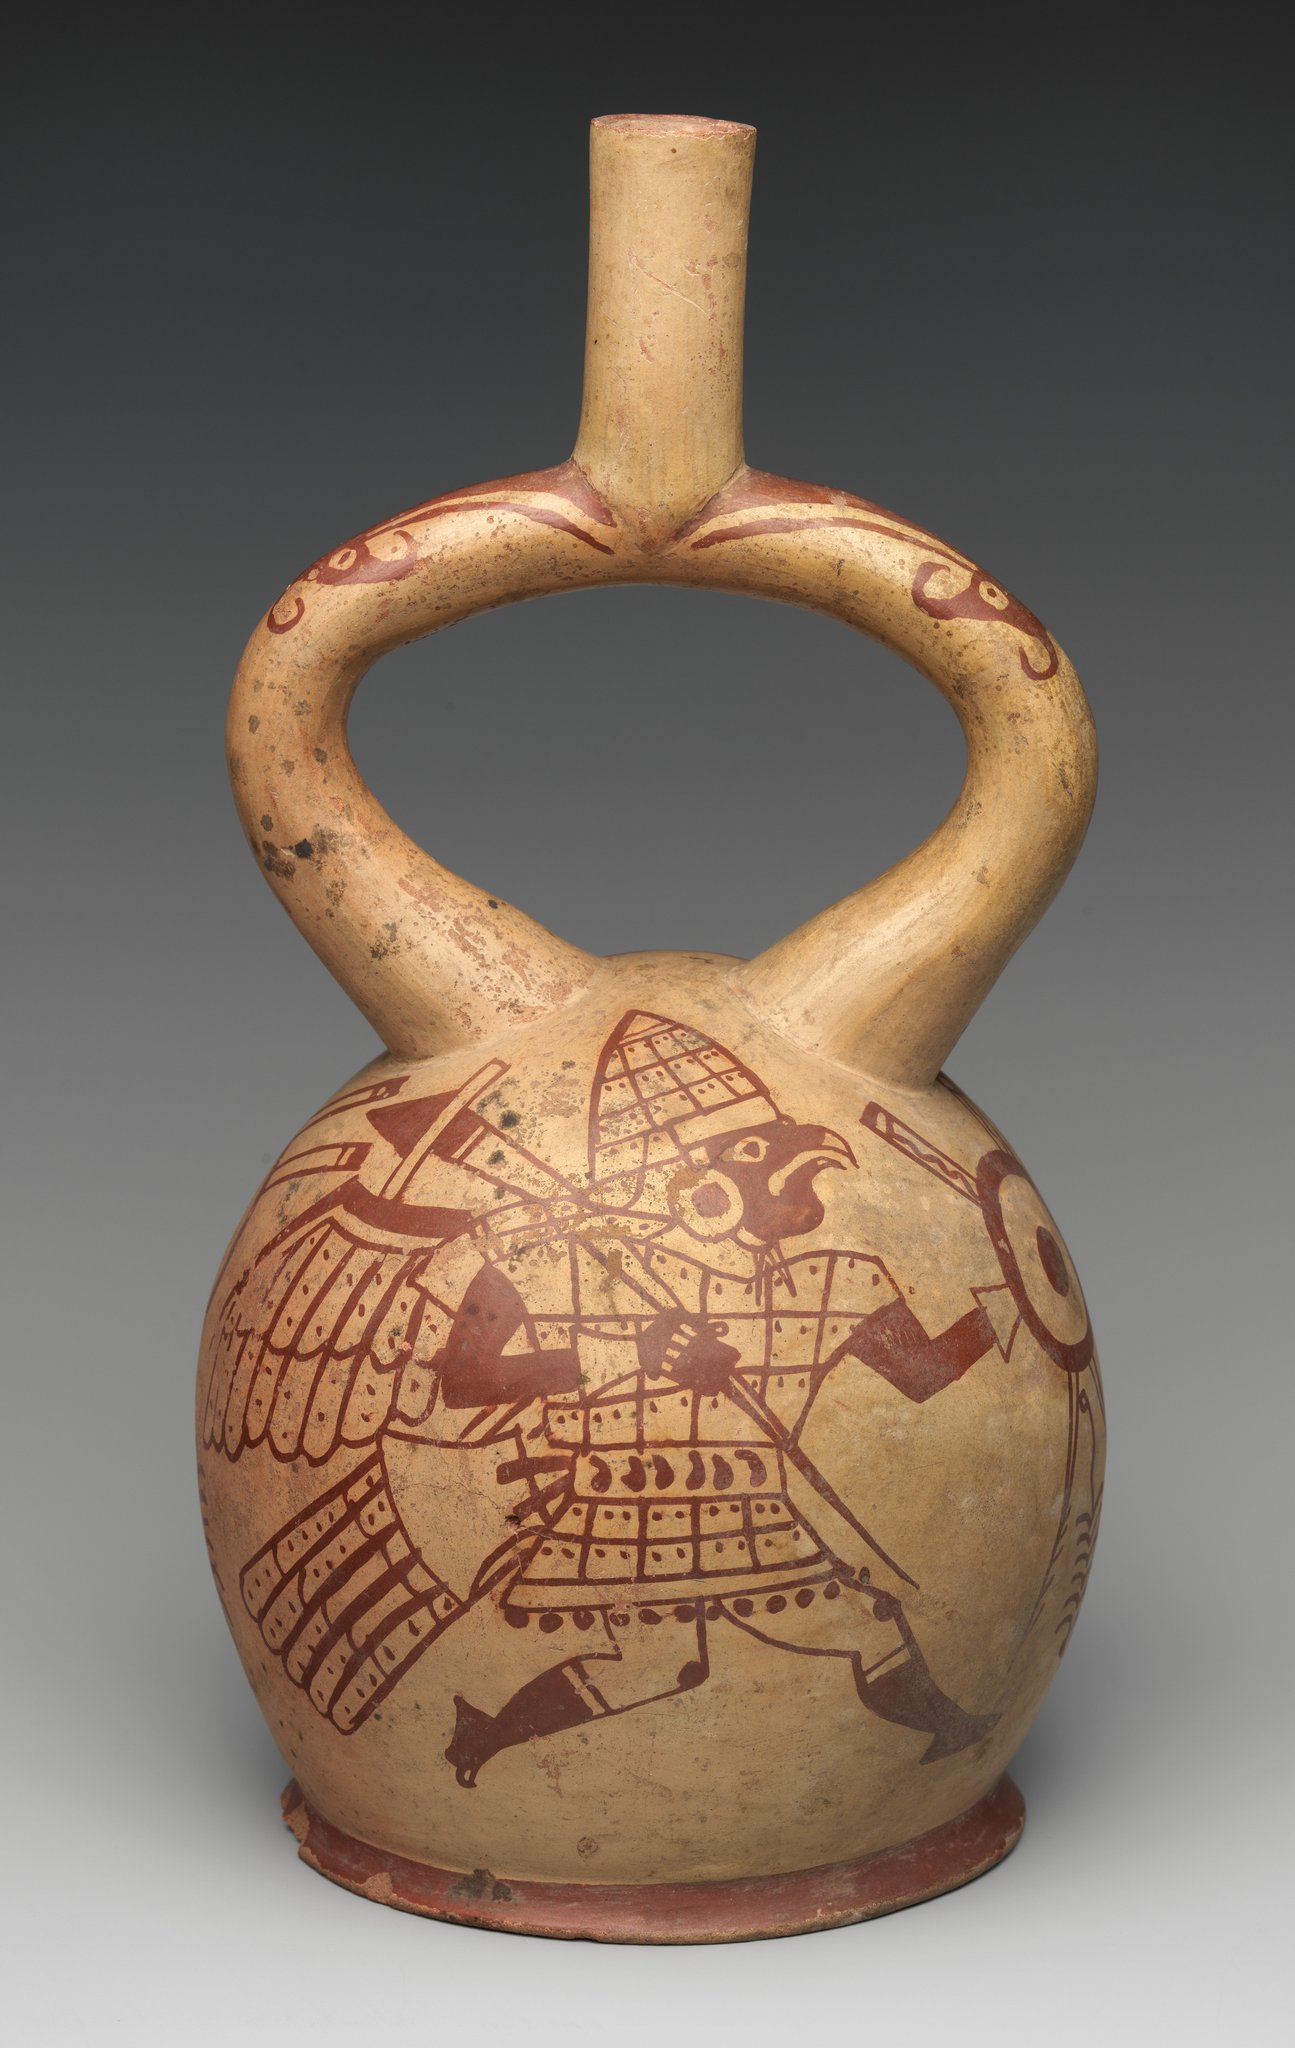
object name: bottle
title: Bird Warrior Bottle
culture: moche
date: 301-700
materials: ceramic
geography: peru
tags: birds,warriors